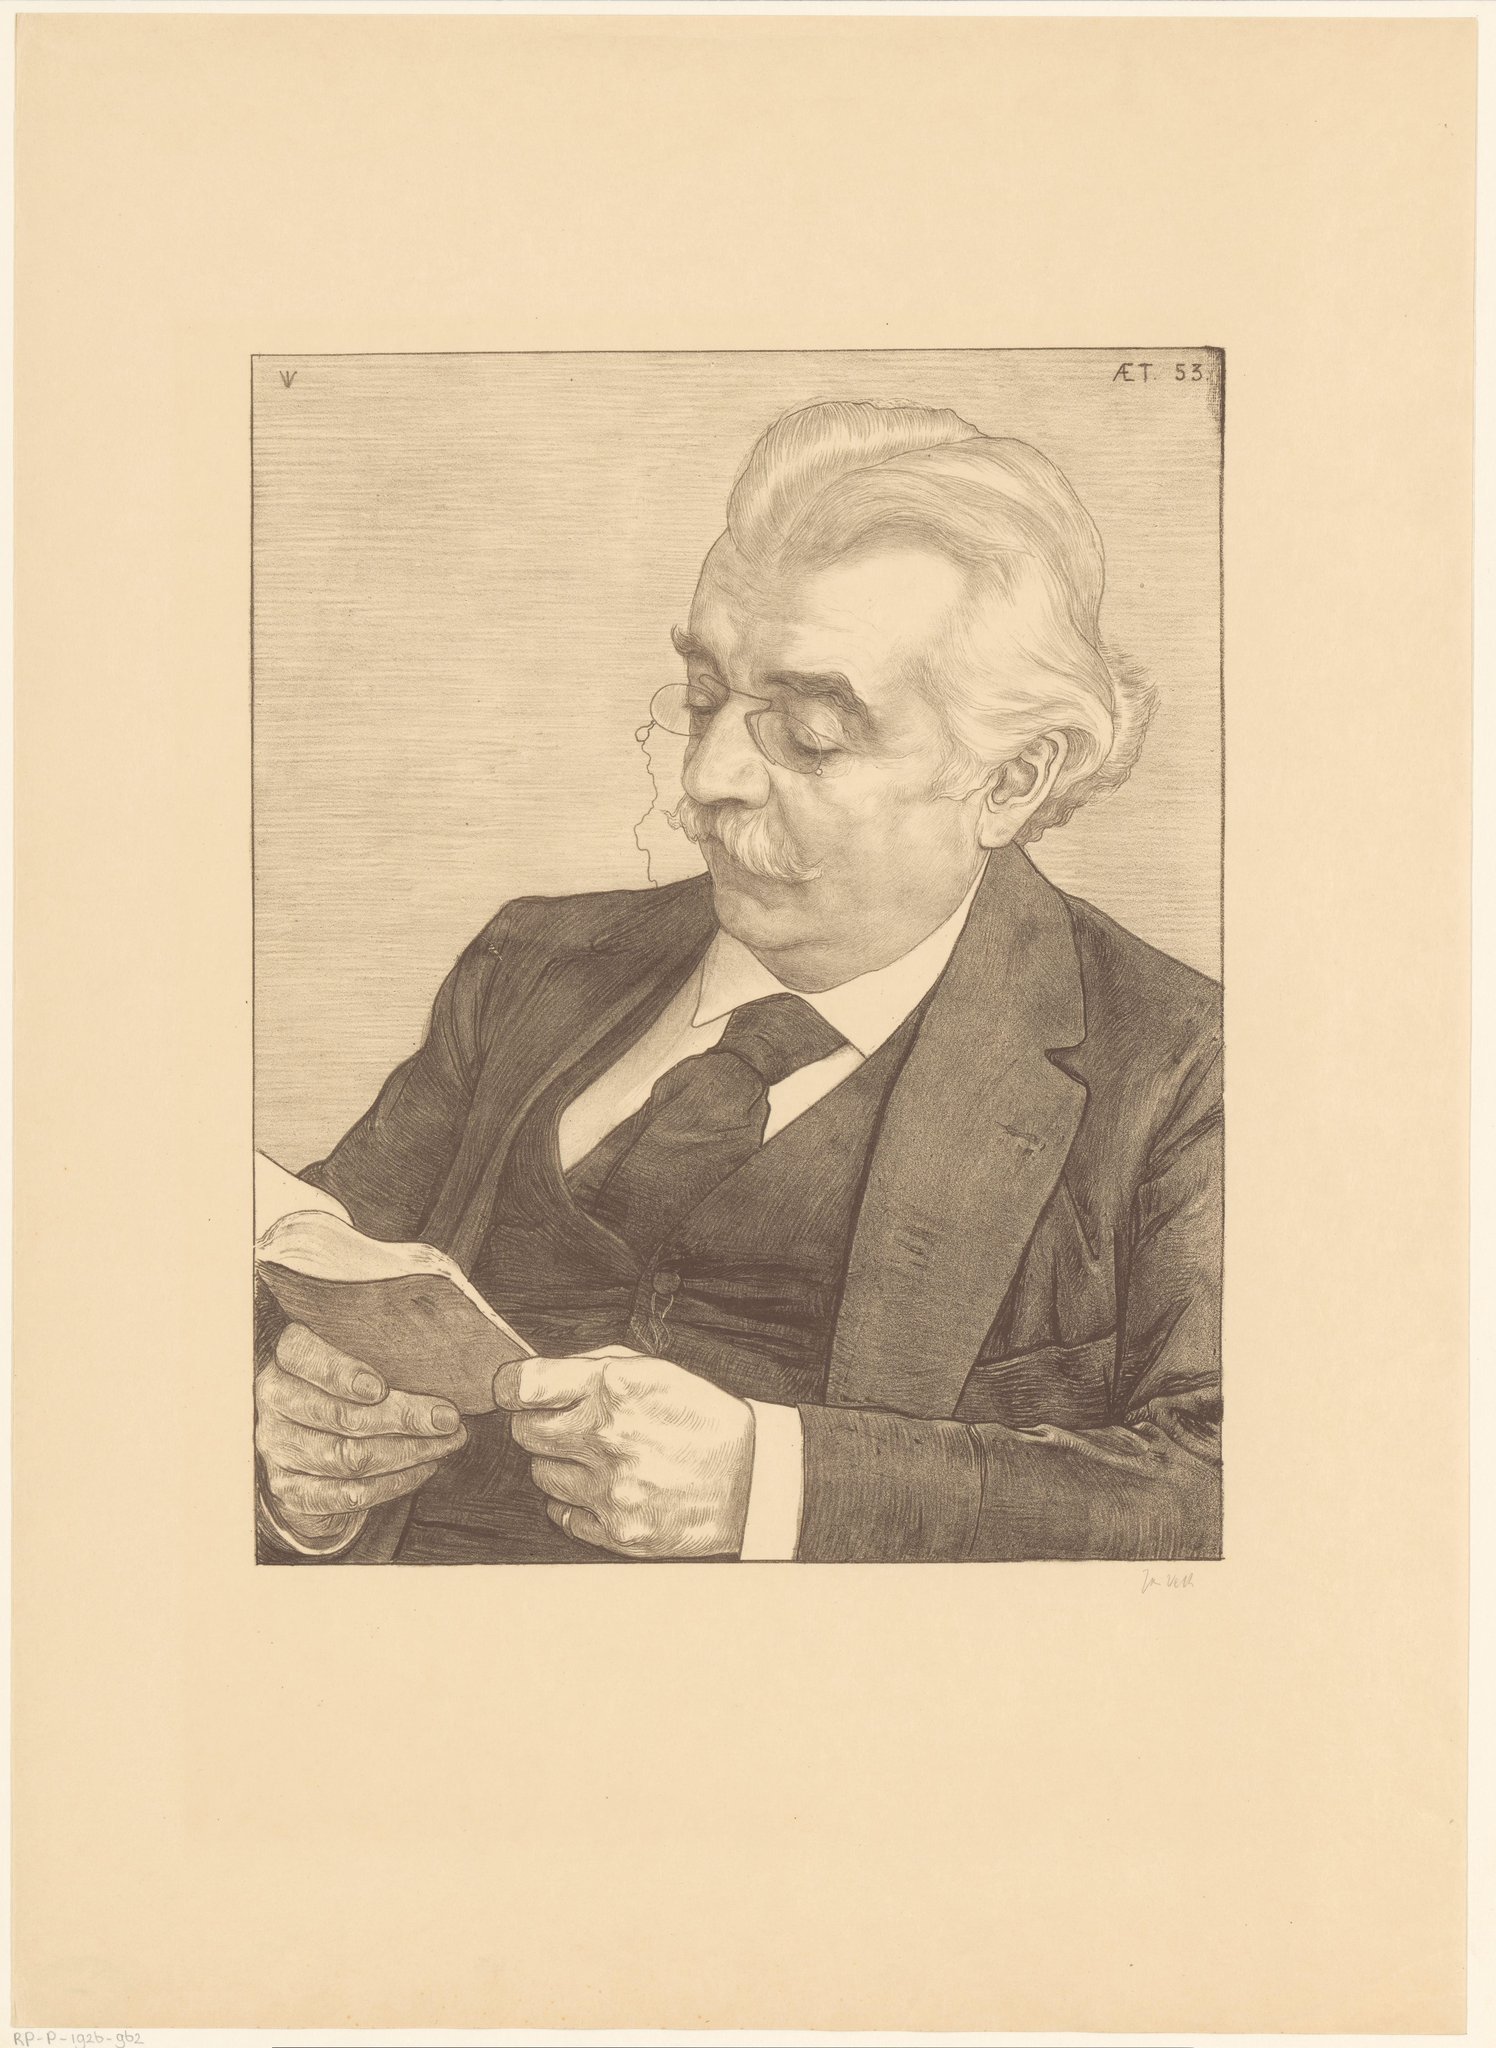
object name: print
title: Bekende tijdgenooten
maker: jan veth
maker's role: designer, draughtsman, painter, print maker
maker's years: 1864-1925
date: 1893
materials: paper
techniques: lithograph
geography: netherlands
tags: amsterdam, politician, jacob nicolaas van hall, historical persons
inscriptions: collector's mark: Lugt 2228, inscription: ‘Jan Veth’, collector's mark: ‘H.G. Samson Amsterdam’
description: Deze prent werd uitgegeven als bijvoegsel van De Amsterdammer op 16 april 1893.